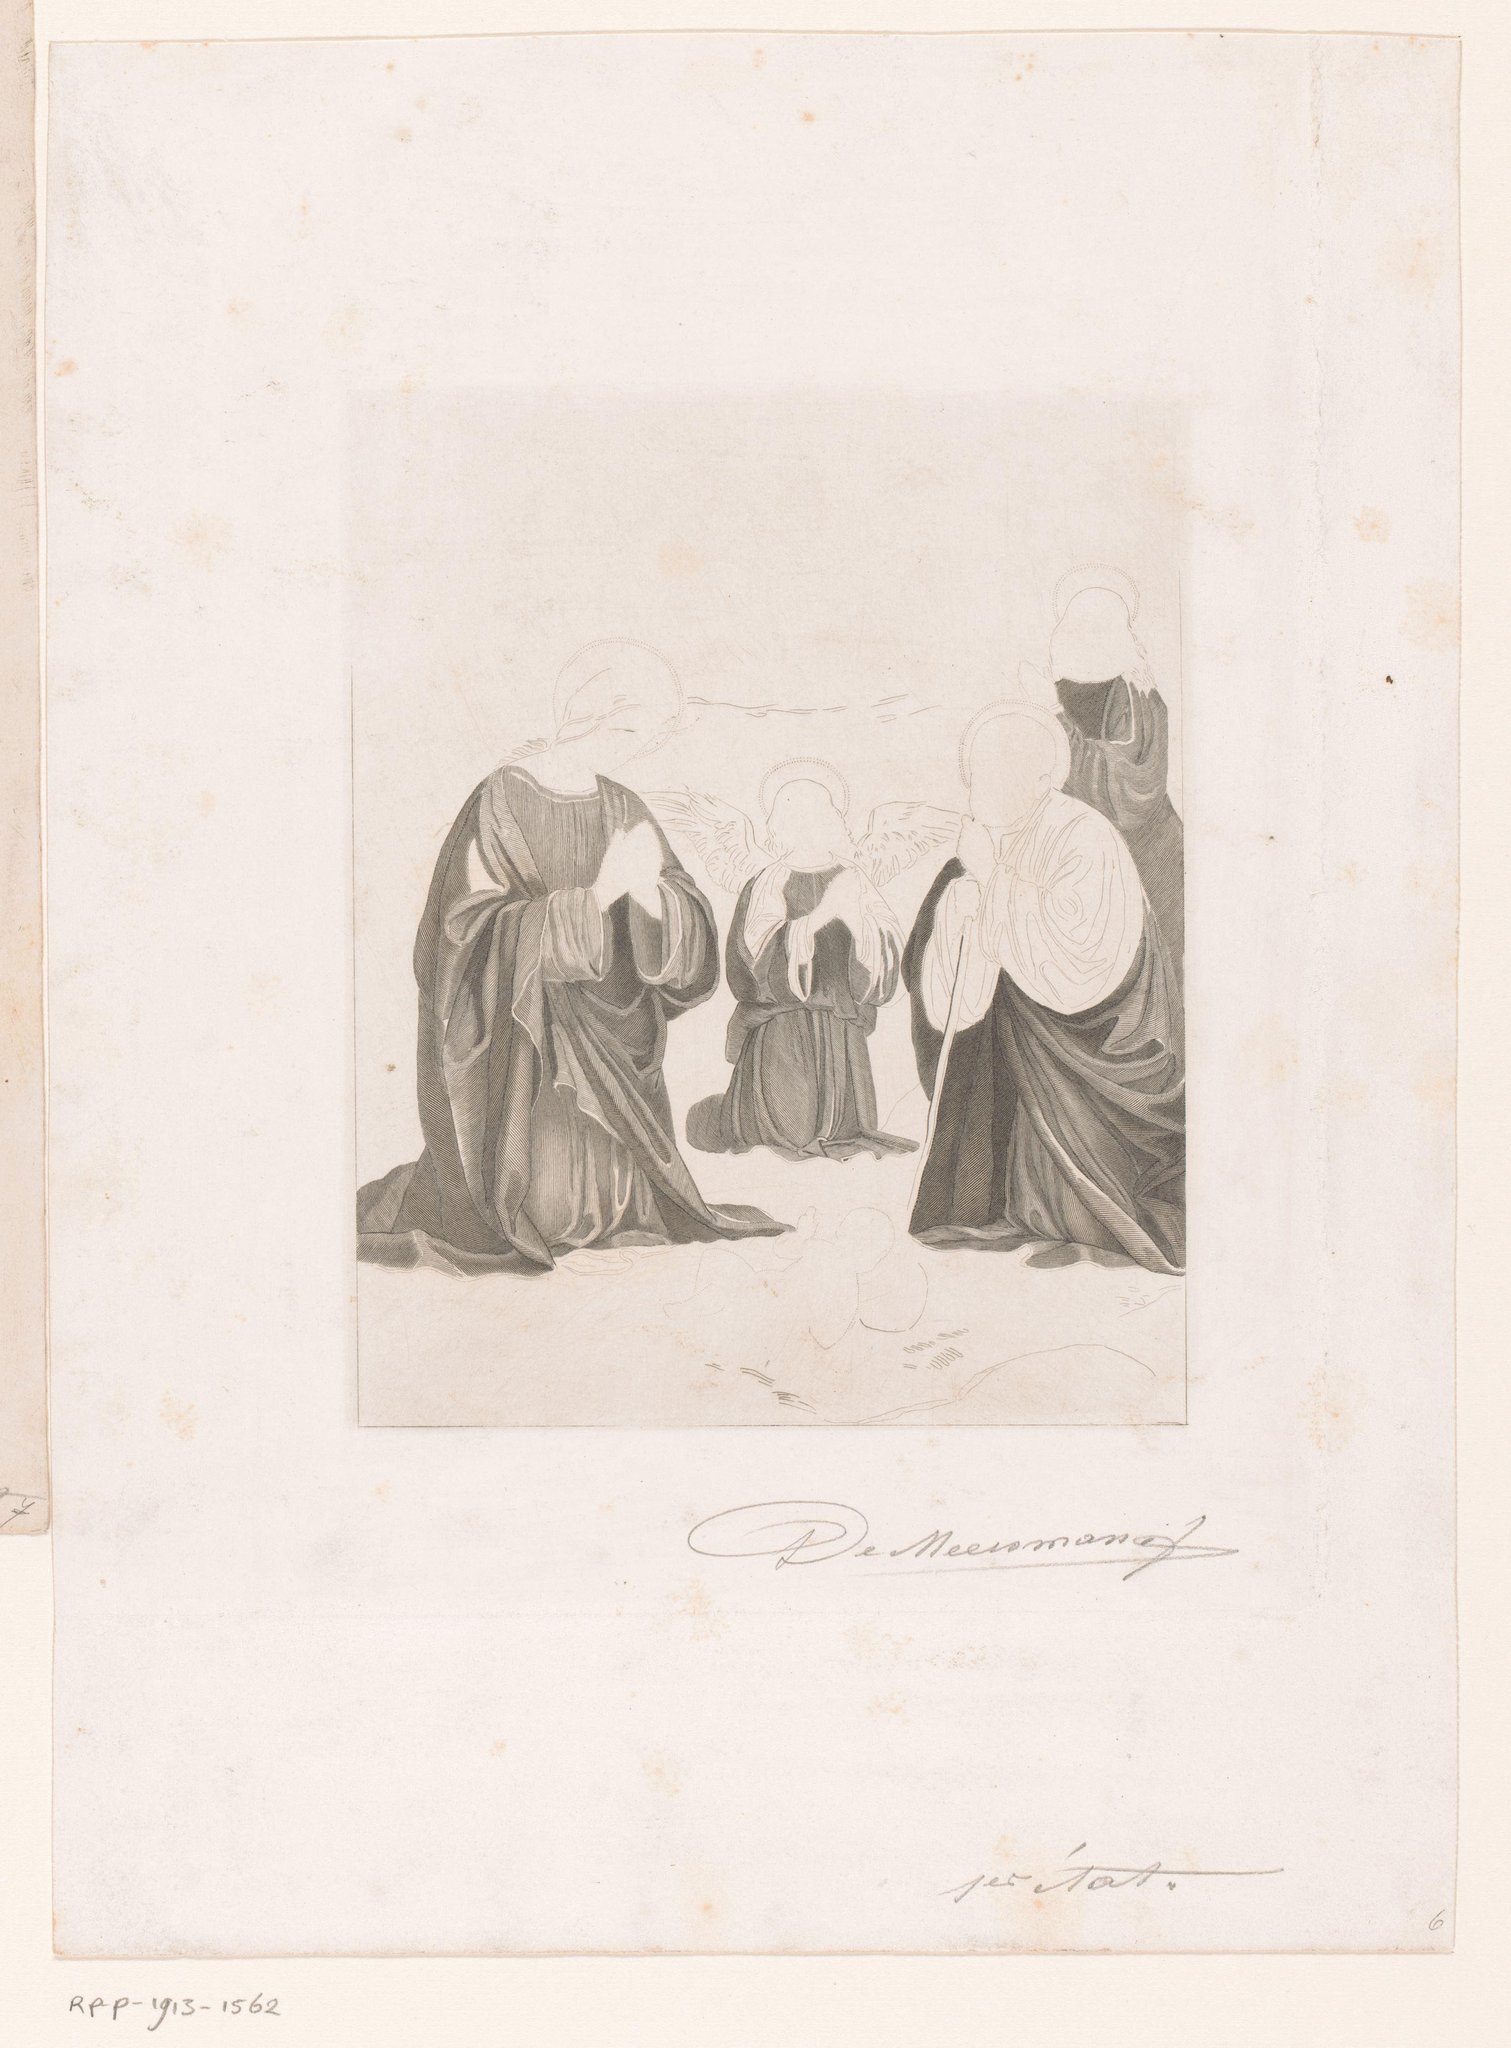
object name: print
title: Geboorte van Christus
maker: françois de meersman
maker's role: print maker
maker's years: 1830-1905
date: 1840-1905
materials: paper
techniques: etching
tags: story of the birth of christ (luke 2:1-20), (high) hill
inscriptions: inscription: ‘1er état’, collector's mark: Lugt 2228